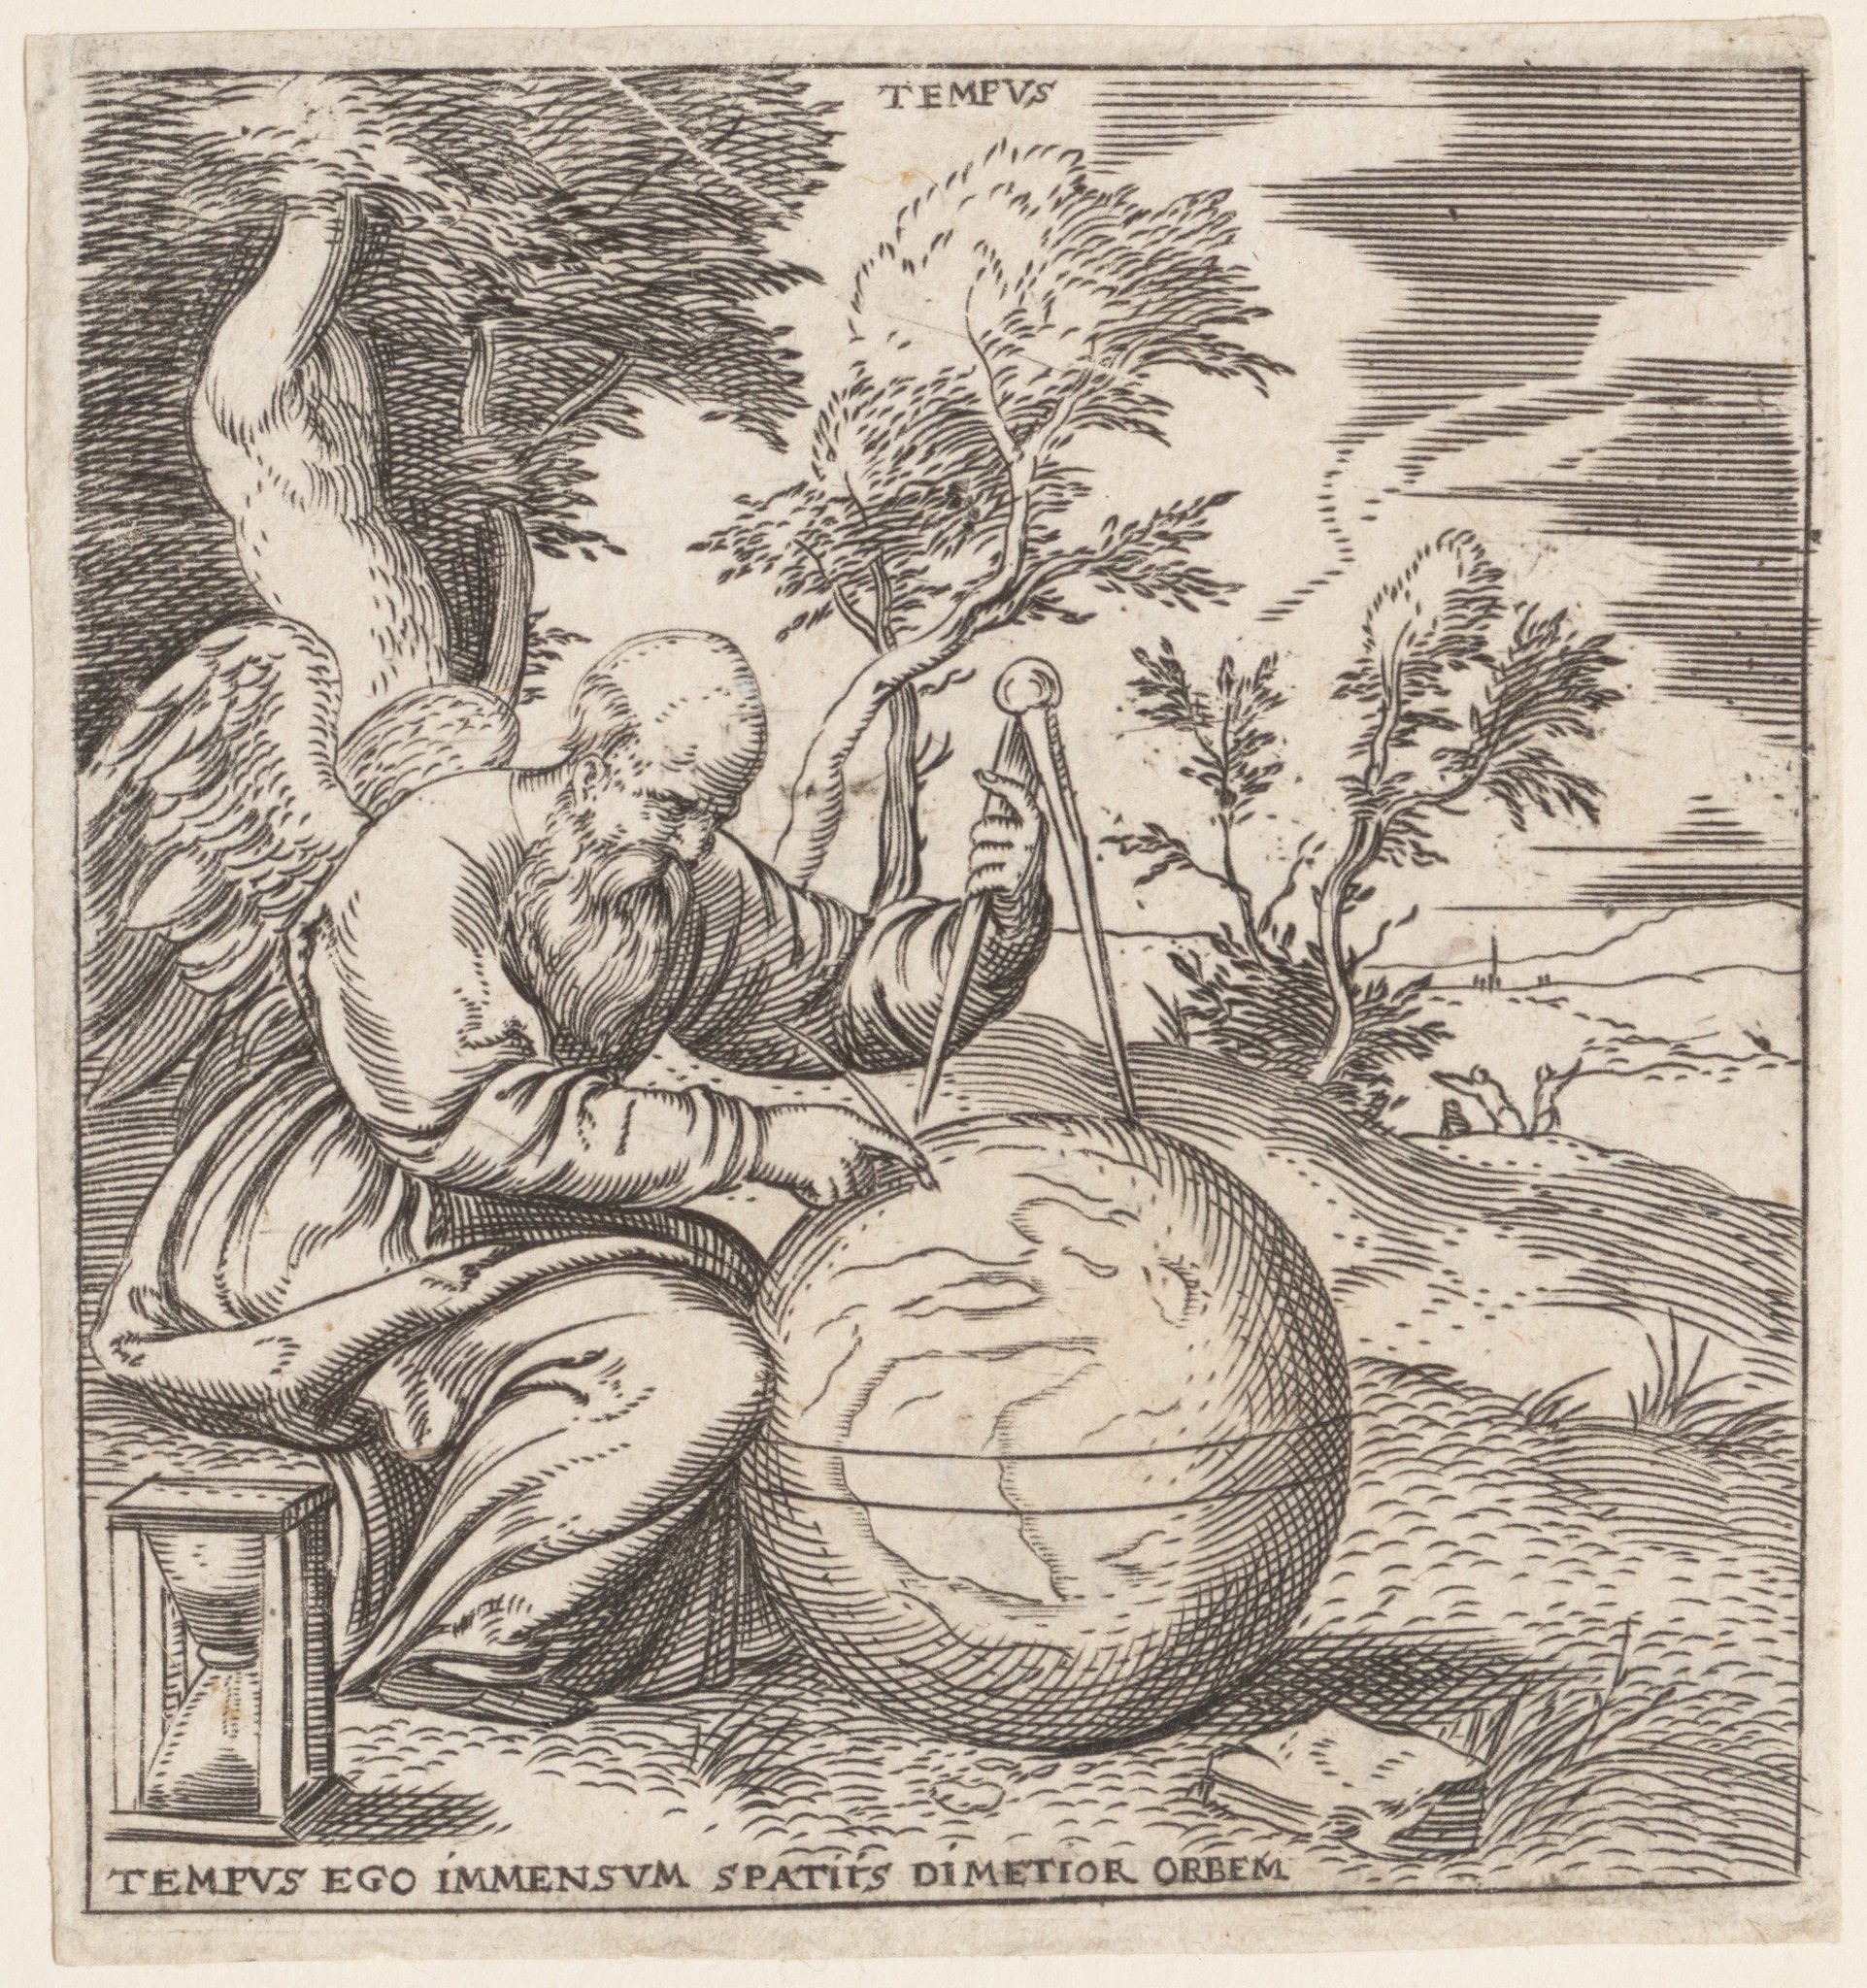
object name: print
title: Time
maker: enea vico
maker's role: artist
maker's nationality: italian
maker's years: 1523-1567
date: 1545-1550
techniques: engraving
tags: hourglass,globes